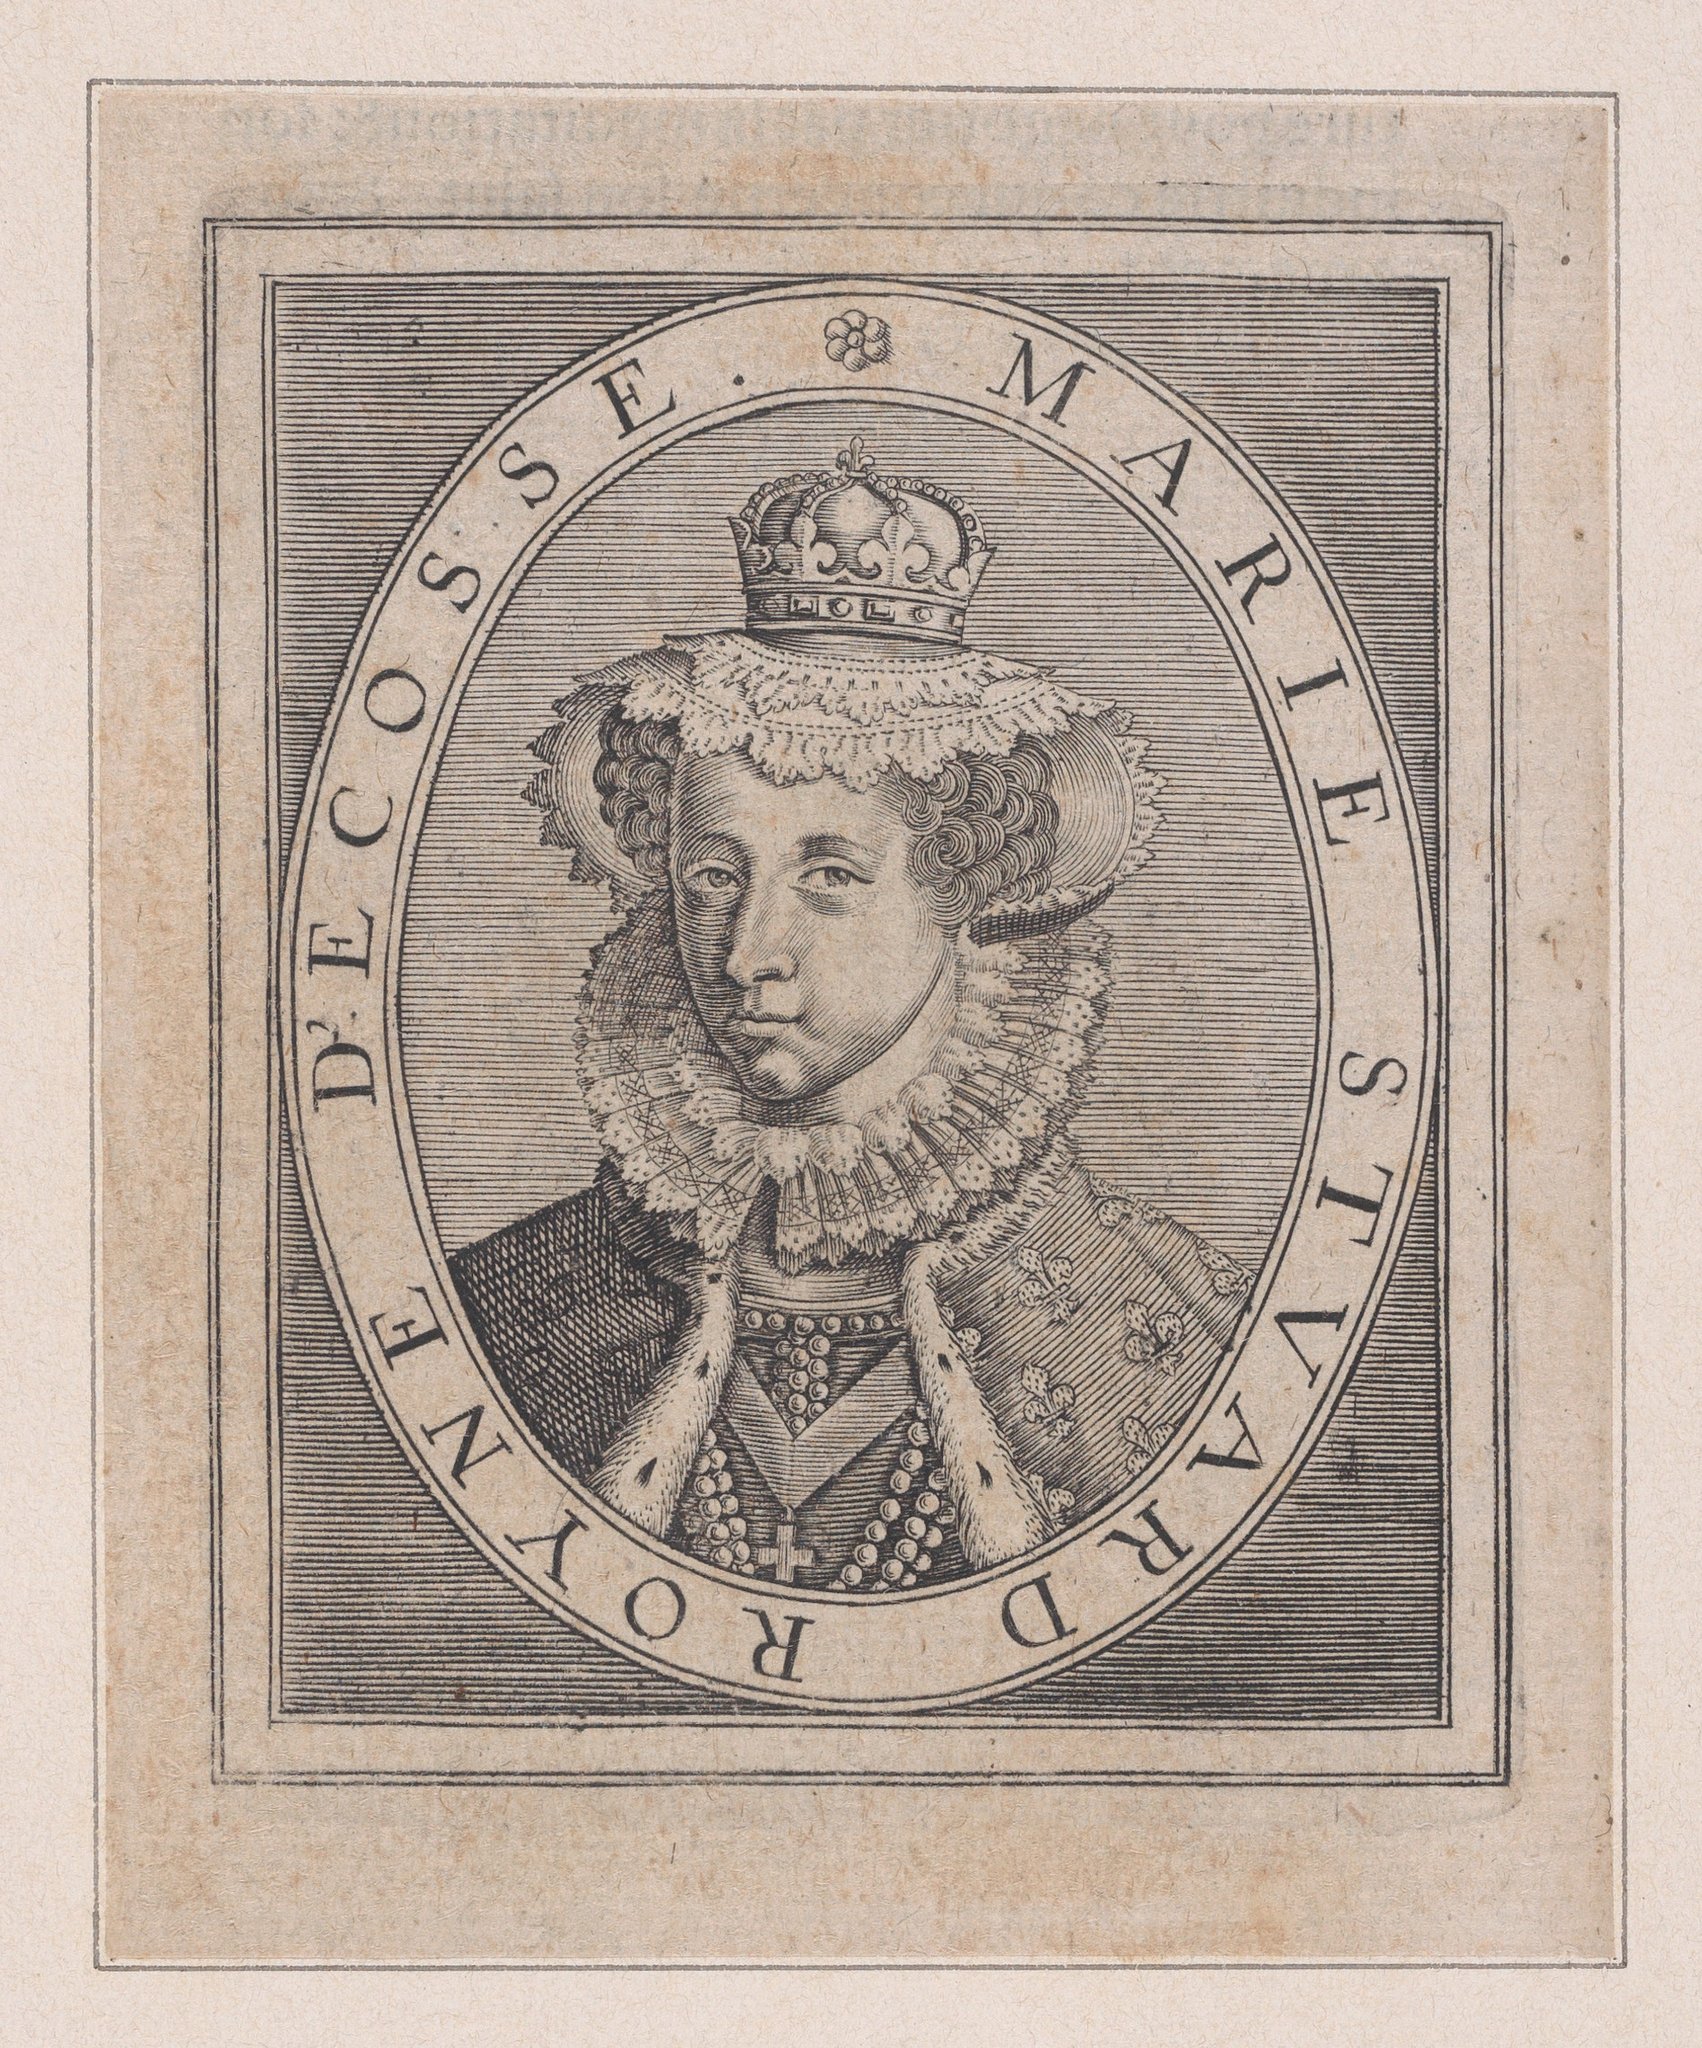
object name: print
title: Marie Stuard Royne d'Ecosse (from "La Cour Sainte du R. pere Nicolas Caussin de la Compagnie de Jesus")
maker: nicolas caussin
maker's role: author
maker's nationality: french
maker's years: 1583-1651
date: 1601-1700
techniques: engraving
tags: portraits,women,mary queen of scots